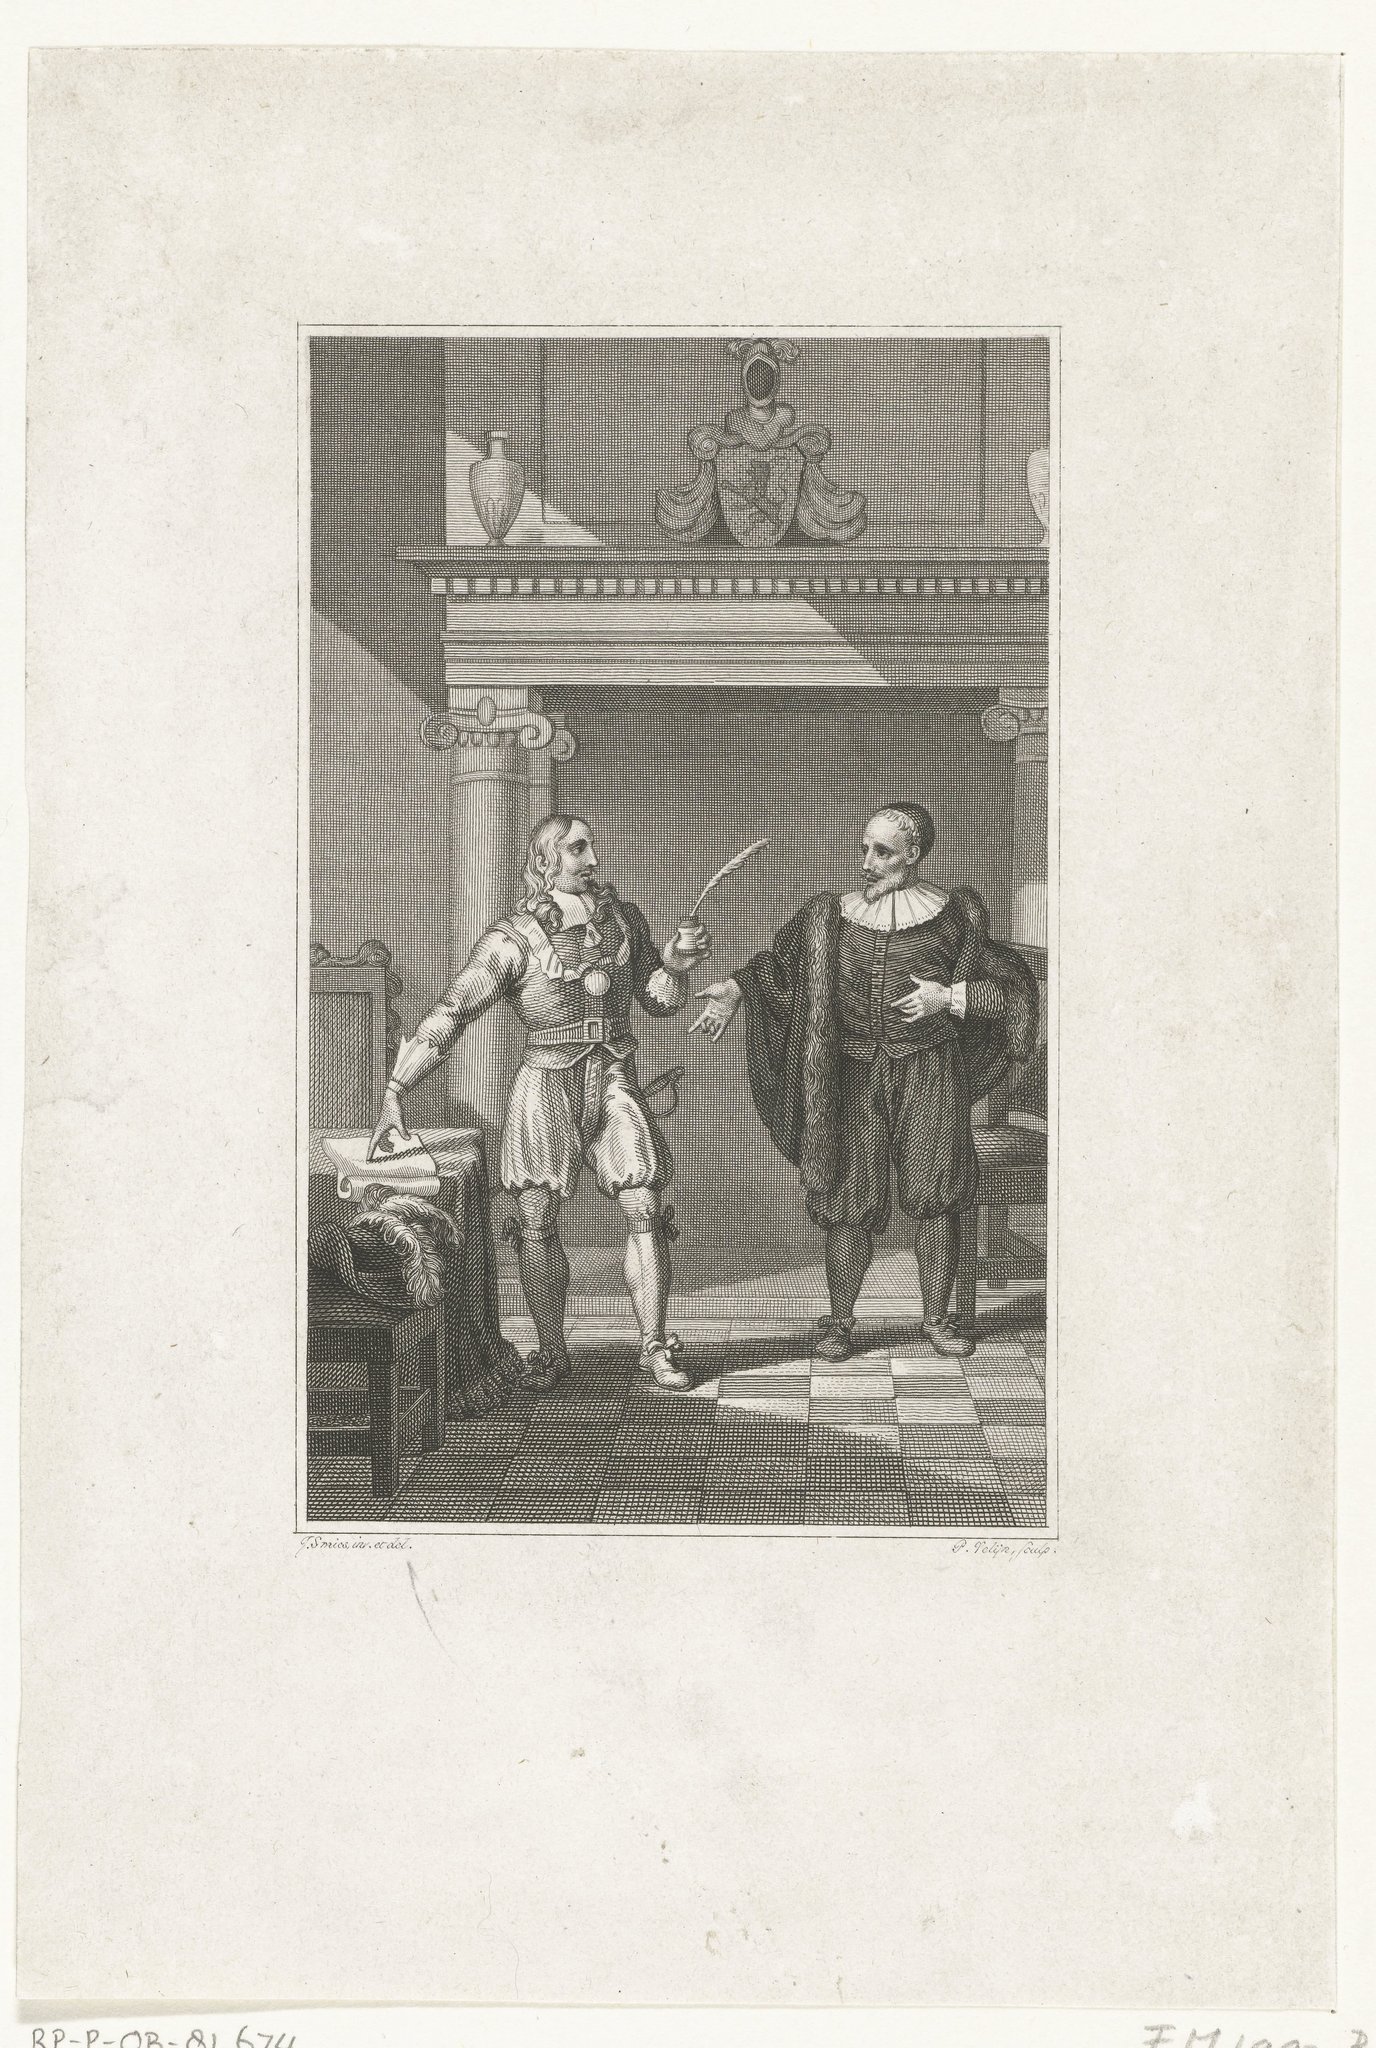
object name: history print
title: Ontmoeting van de raadpensionaris Cats met Willem II, 1650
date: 1823-1829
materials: paper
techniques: etching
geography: netherlands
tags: william ii (prince of orange), the hague, jacob cats (1577-1660)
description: Gebruikt als illustratie in: P.G. Witsen Geysbeek en G. Engelberts Gerrits, Schoonheden en merkwaardige tafereelen uit de Nederlandsche geschiedenis. G. Portielje, Amsterdam 1825-1829, 8 delen. Dit nummer is een door het RPK toegevoegd nummer en staat niet in Frederik Muller, het werk waar de prent voor is gemaakt of uit afkomstig is, staat wel vermeld in Frederik Muller.